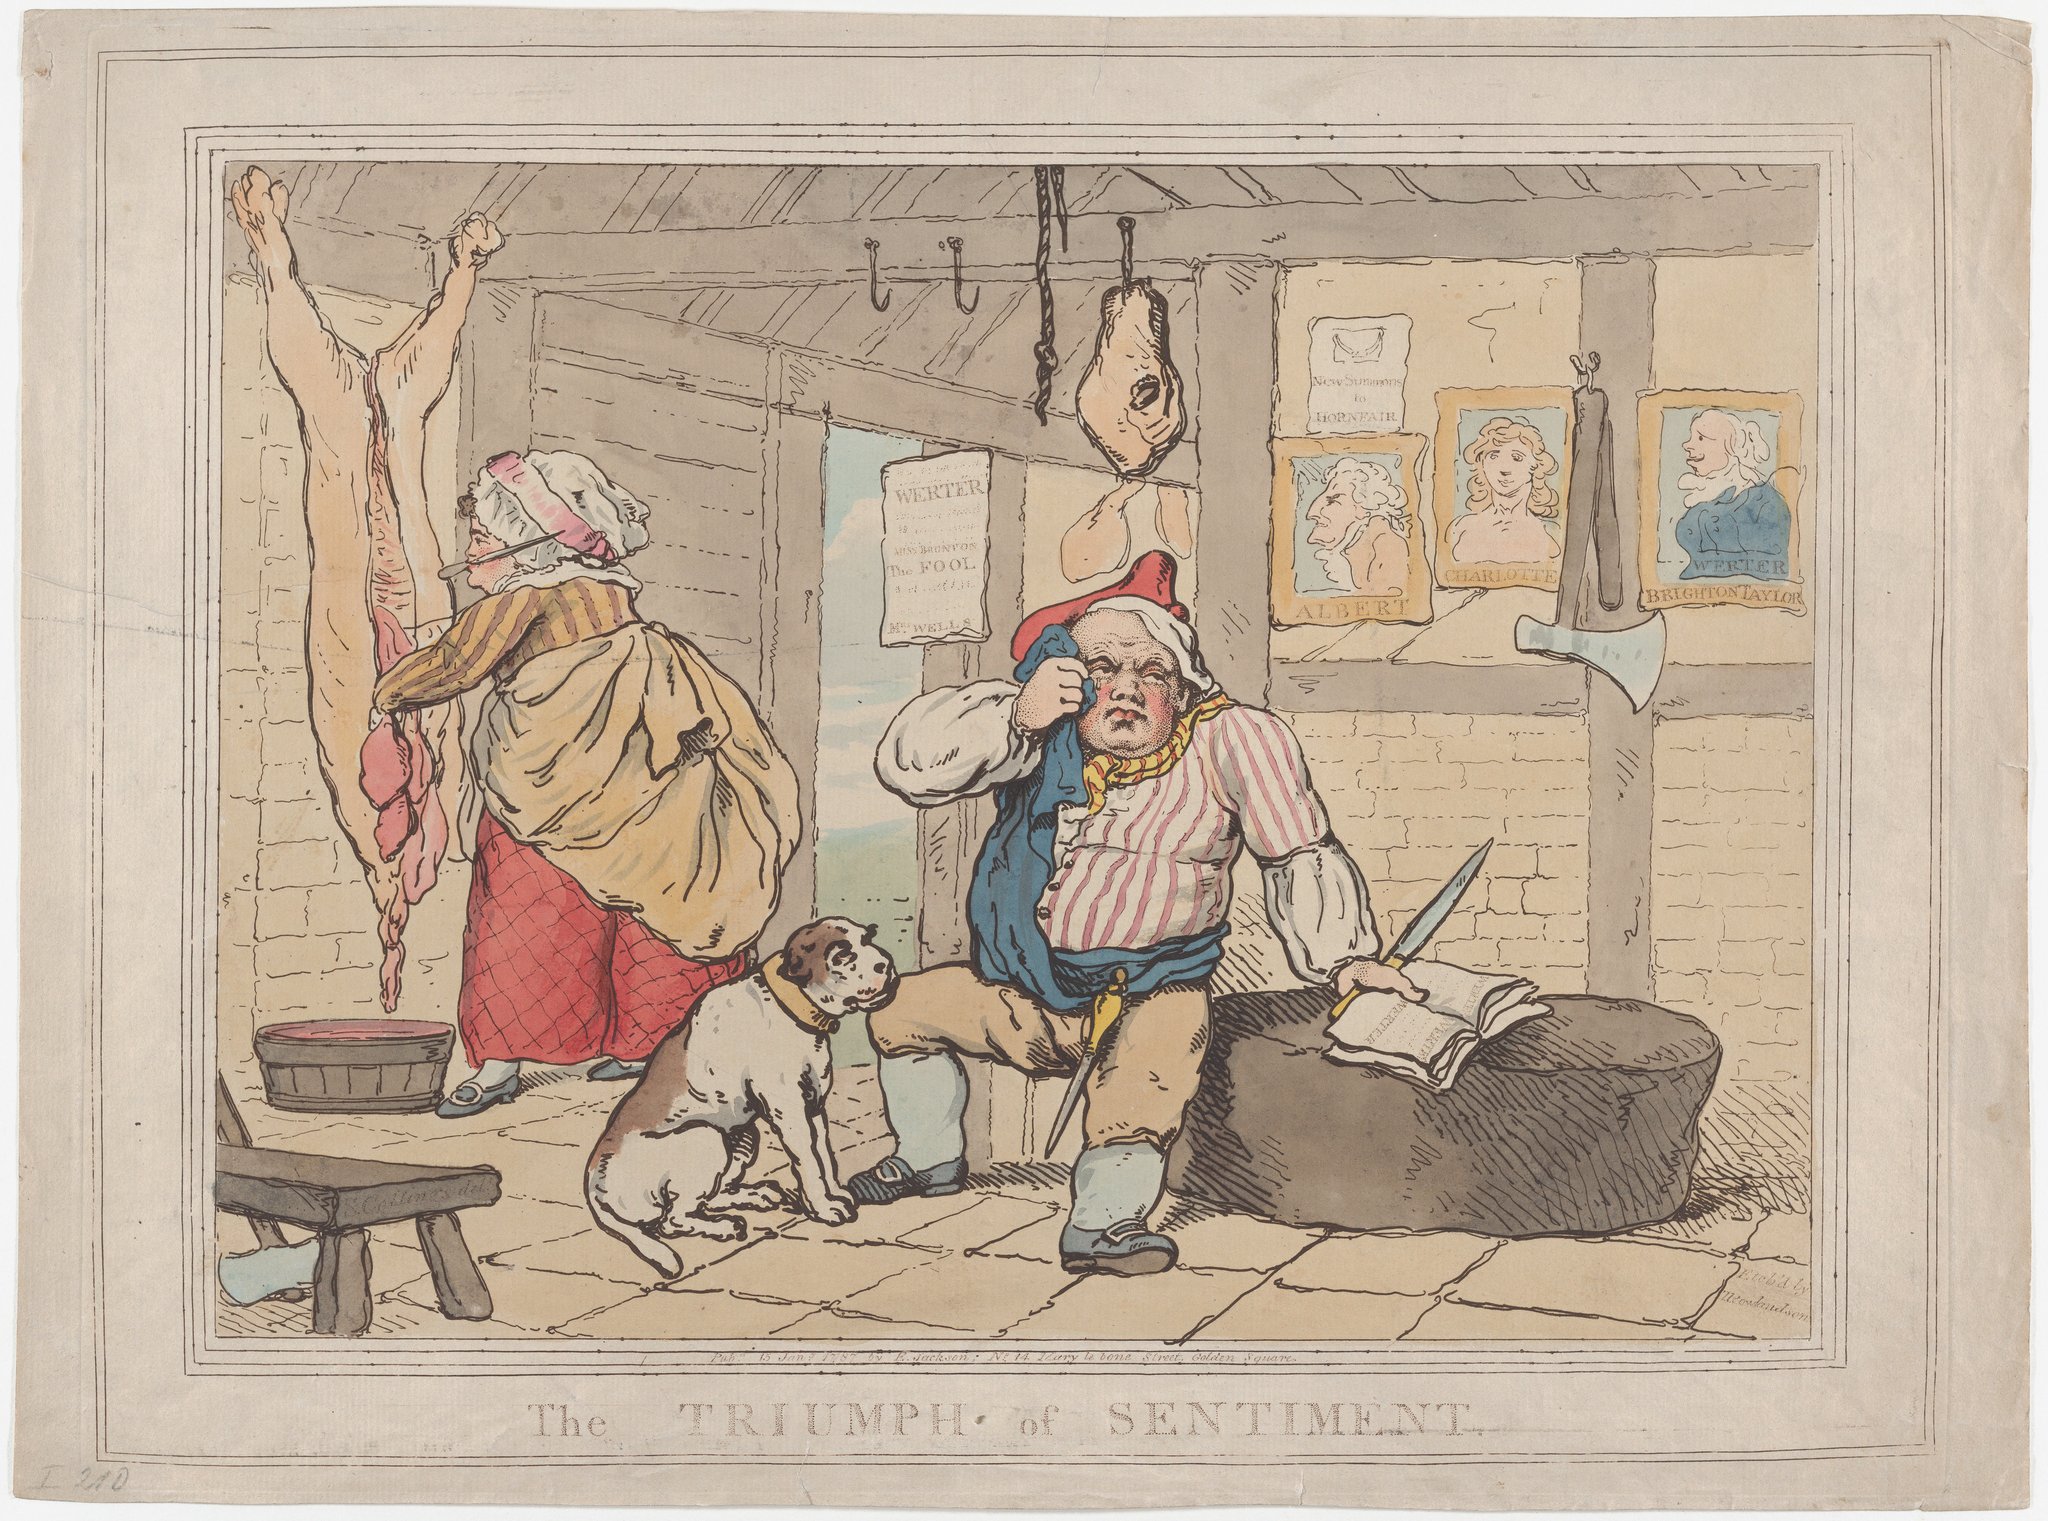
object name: print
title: The Triumph of Sentiment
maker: thomas rowlandson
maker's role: artist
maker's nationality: british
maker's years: 1757-1827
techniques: aquatint, etching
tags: men,women,dogs,axes